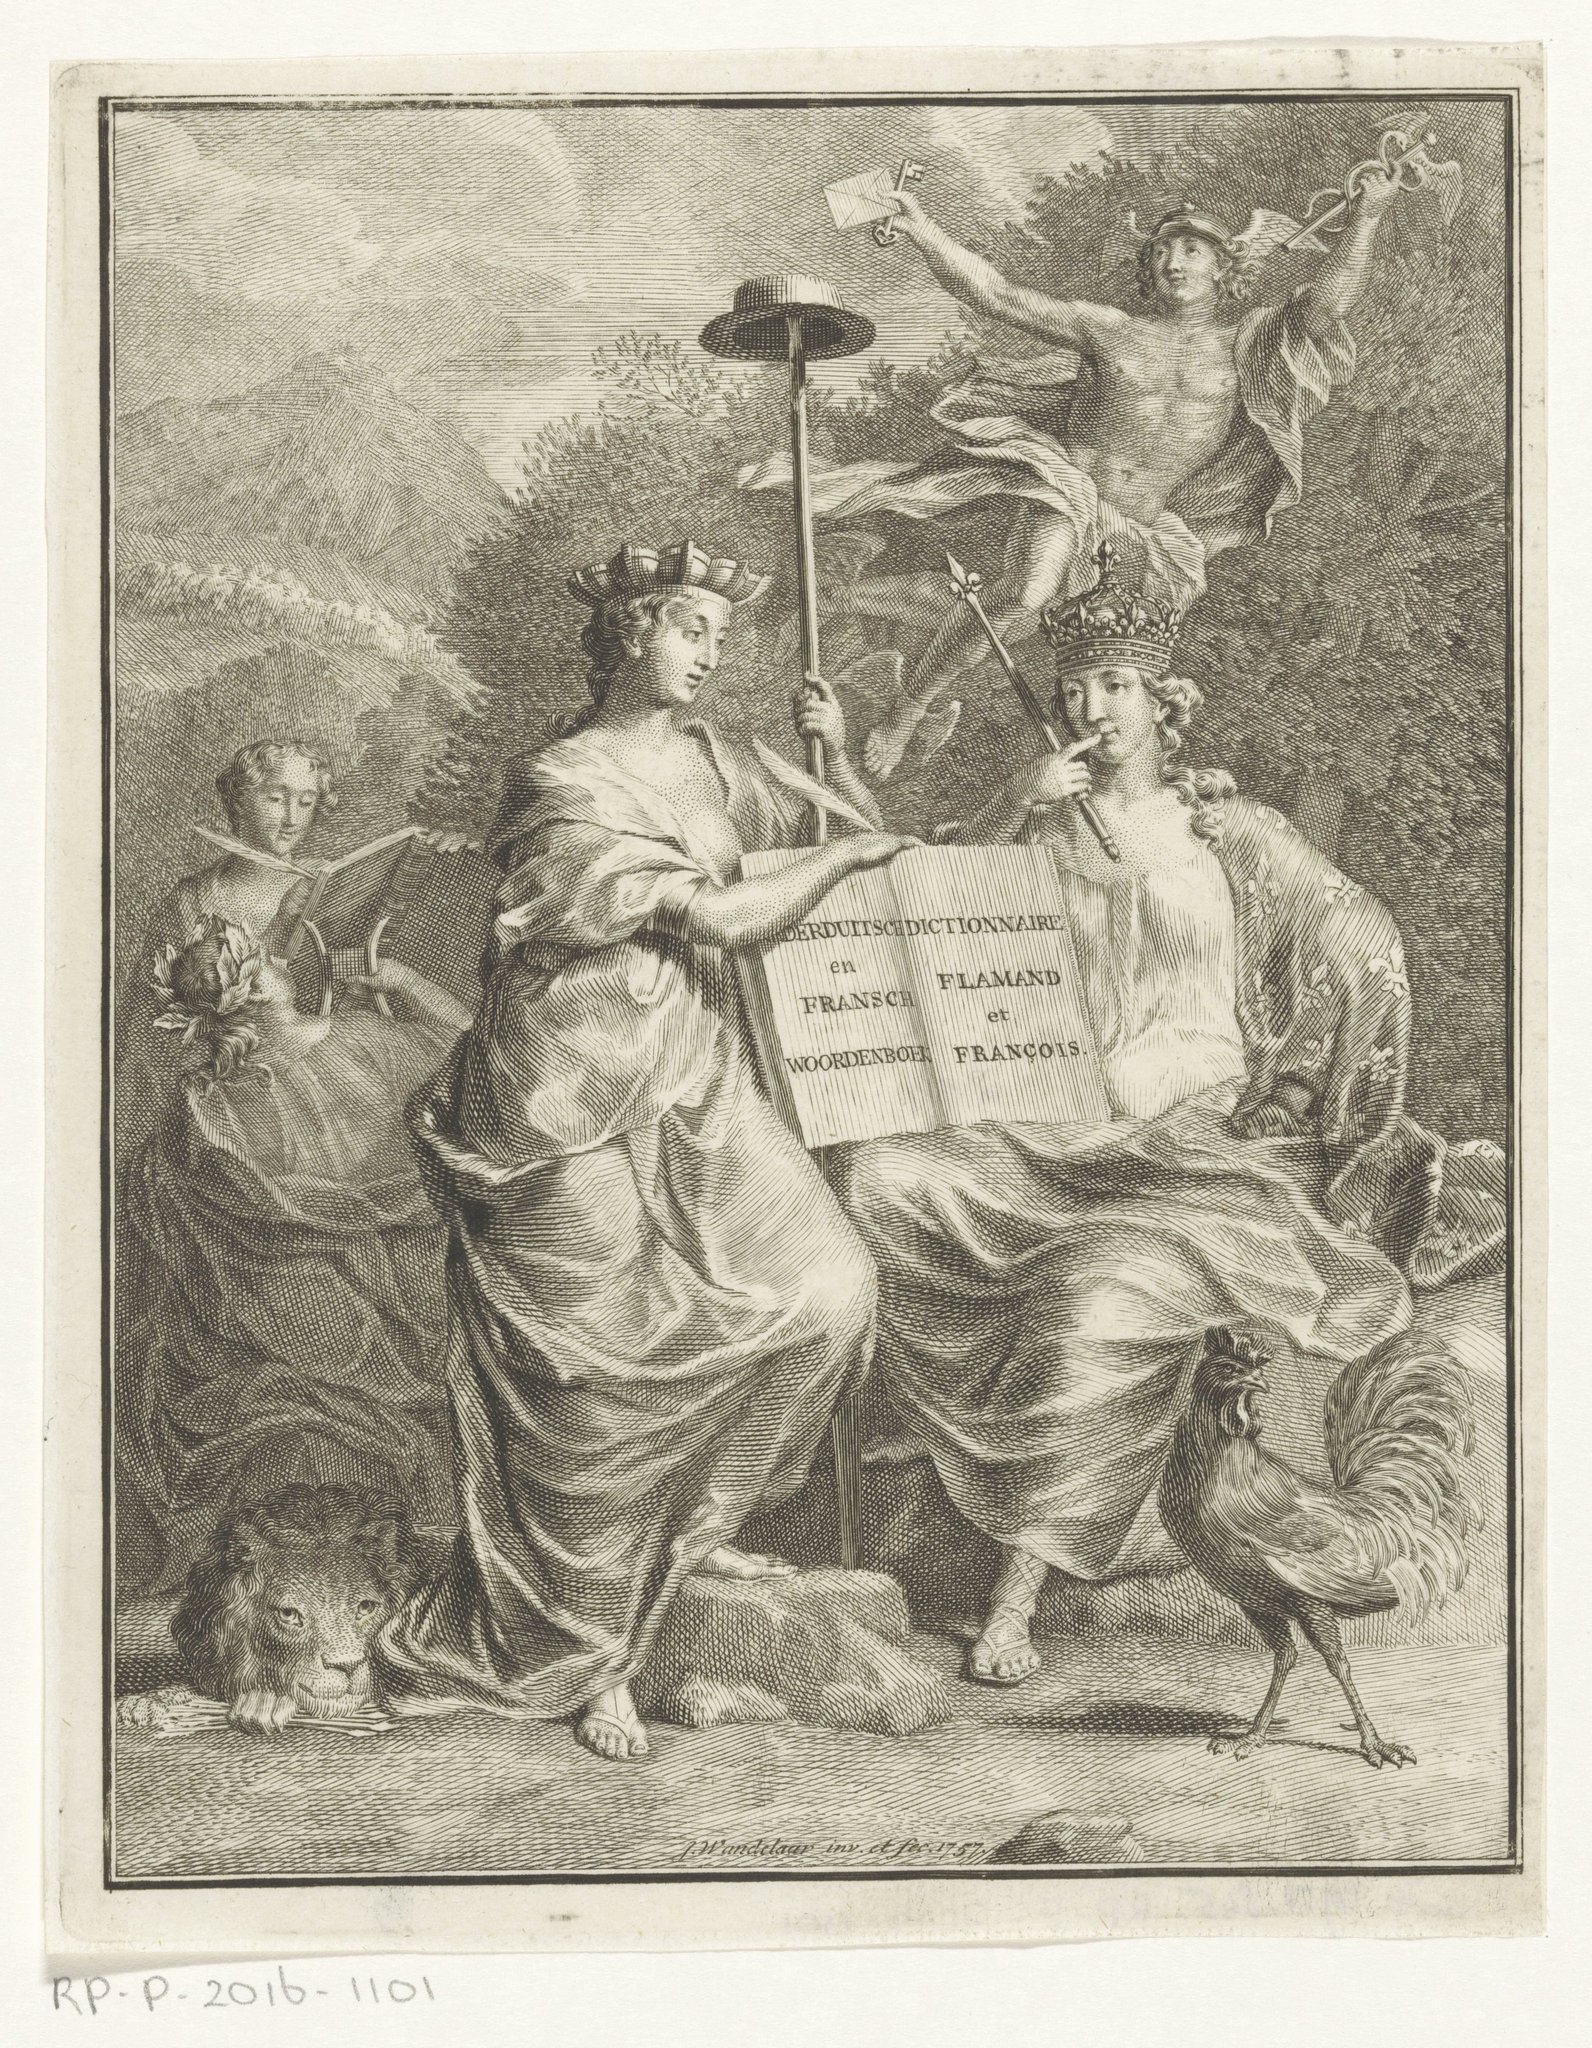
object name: titelblad, titelpagina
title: Personificaties van de Oostenrijkse Nederlanden en Frankrijk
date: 1757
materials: paper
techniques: engraving, etching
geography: leiden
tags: personifications of countries, nations, states, districts, etc., title-page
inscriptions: collector's mark: Lugt 2228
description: In het midden zit de personificatie van de Oostenrijkse Nederlanden met een muurkroon en een vrijheidsstaf met hoed. Ze houdt een opengeslagen boek vast met de verkorte titel. Aan haar voeten ligt een leeuw met een pijlenbundel. Links achter haar bespeelt een vrouw een lier en schrijft een andere vrouw in een boek. Aan de andere kant van het opengeslagen boek zit de personificatie van Frankrijk met een kroon, een scepter en een haan aan haar voeten. Achter hen vliegt Mercurius met zijn caduceus, een envelop en een sleutel.